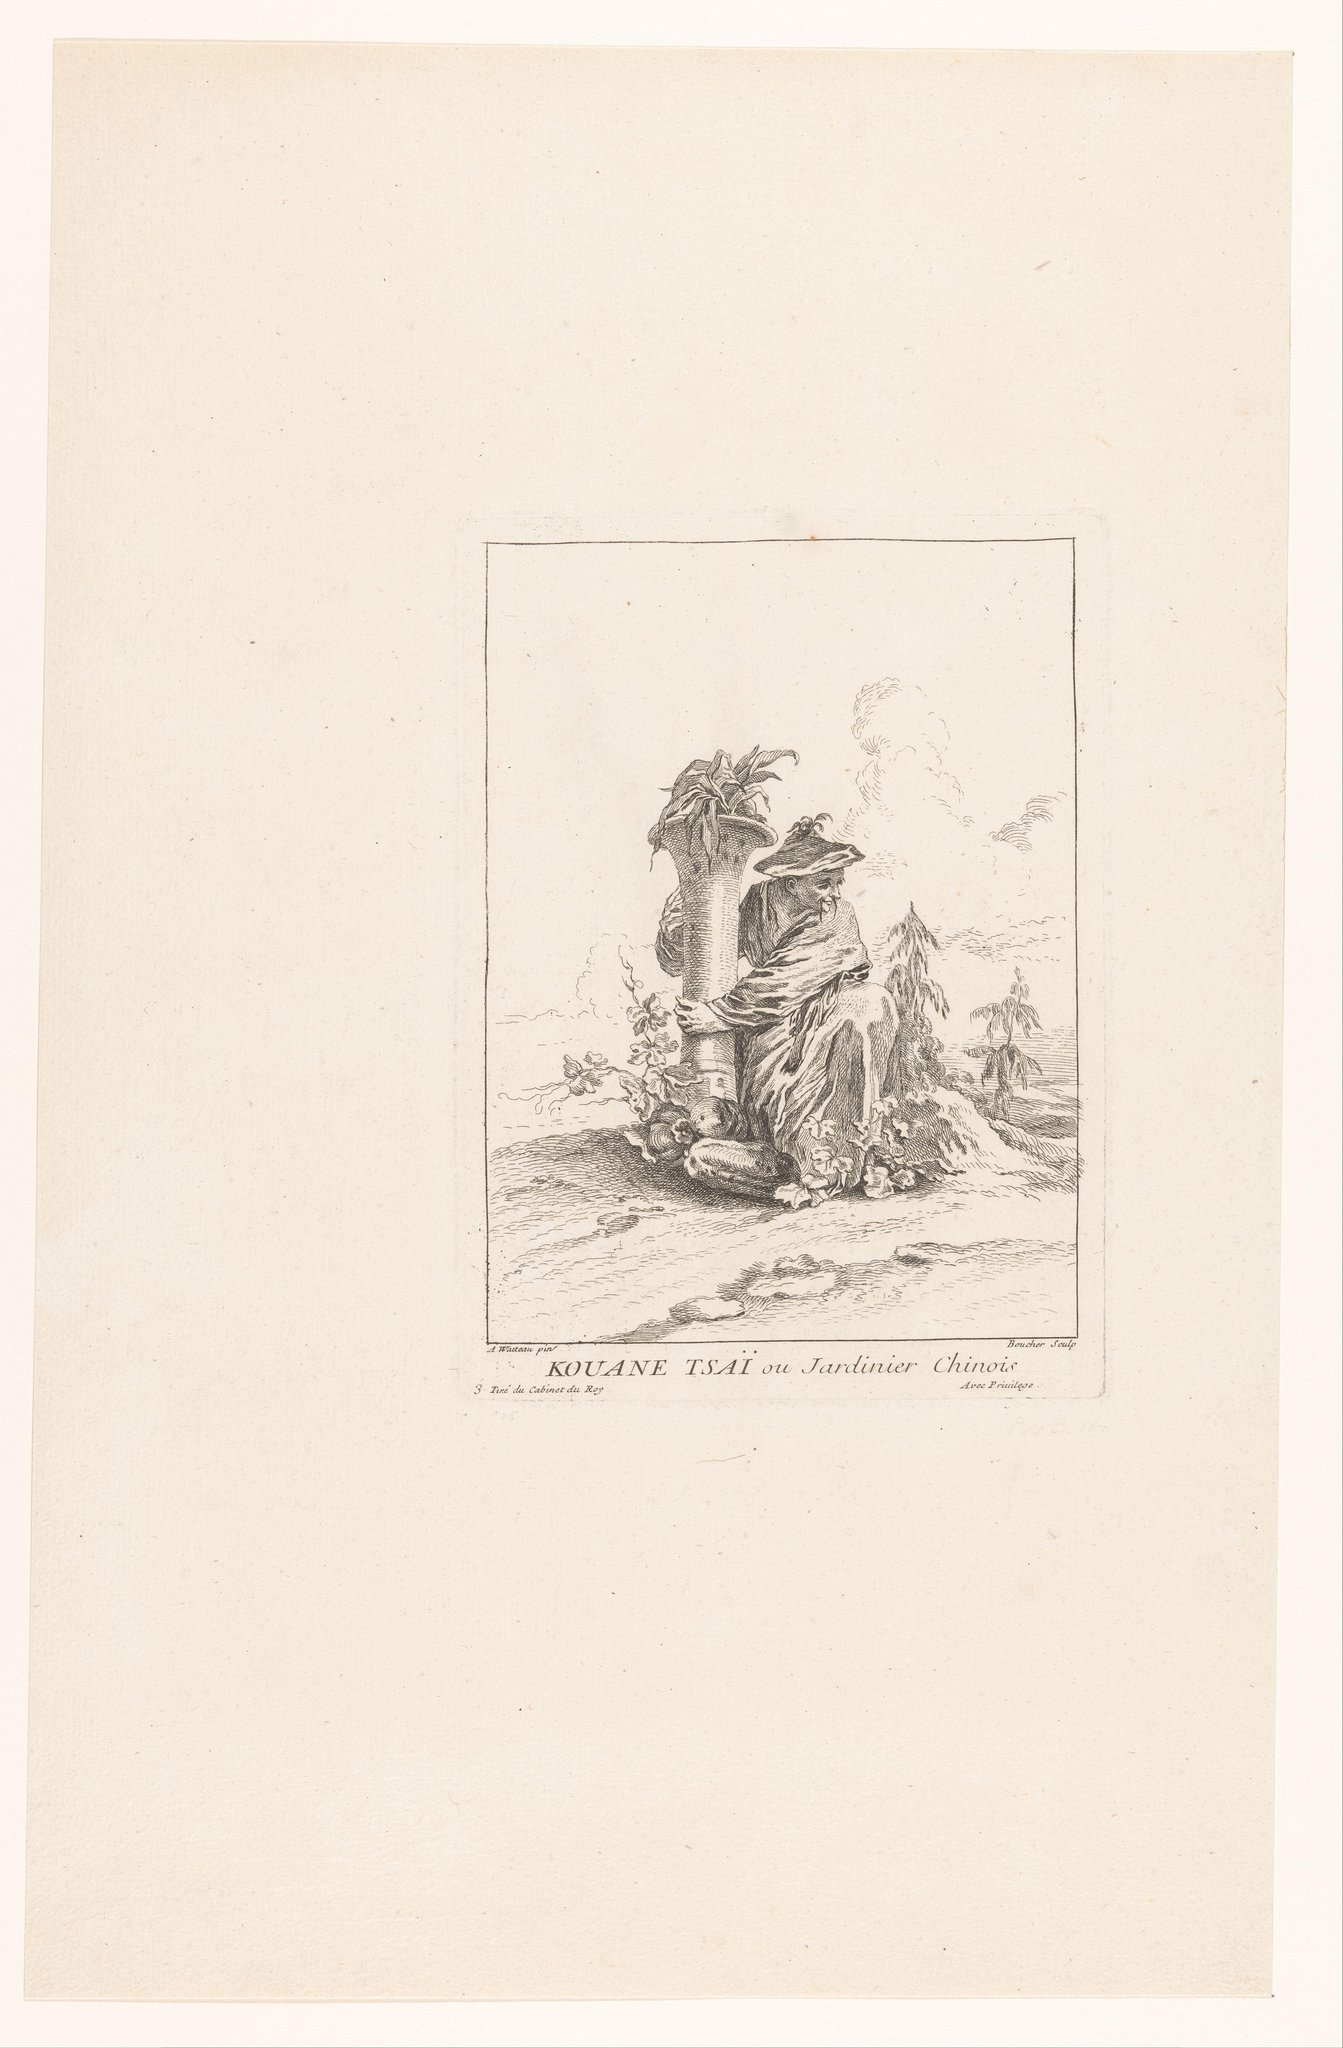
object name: print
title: Verschillende Chinese en Tartaarse figuren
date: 1731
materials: paper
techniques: etching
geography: paris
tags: chinese, gardening, sitting on the ground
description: Maakt deel uit van een serie van 271 platen, inclusief twee titelprenten, naar schilderijen door Watteau en verzameld door Jean de Jullienne. Sommige platen werden reeds tijdens Watteau's leven vervaardigd en de rest kwam pas na zijn dood tot stand. In 1734 werd het eind van de serie aangekondigd. Deze plaat betreft nr. 238 van de serie. Maakt eveneens deel uit van een subgroep van twaalf prenten, getiteld 'Diverses Figures Chinoises et Tartares Peintes par Watteau (...)'.